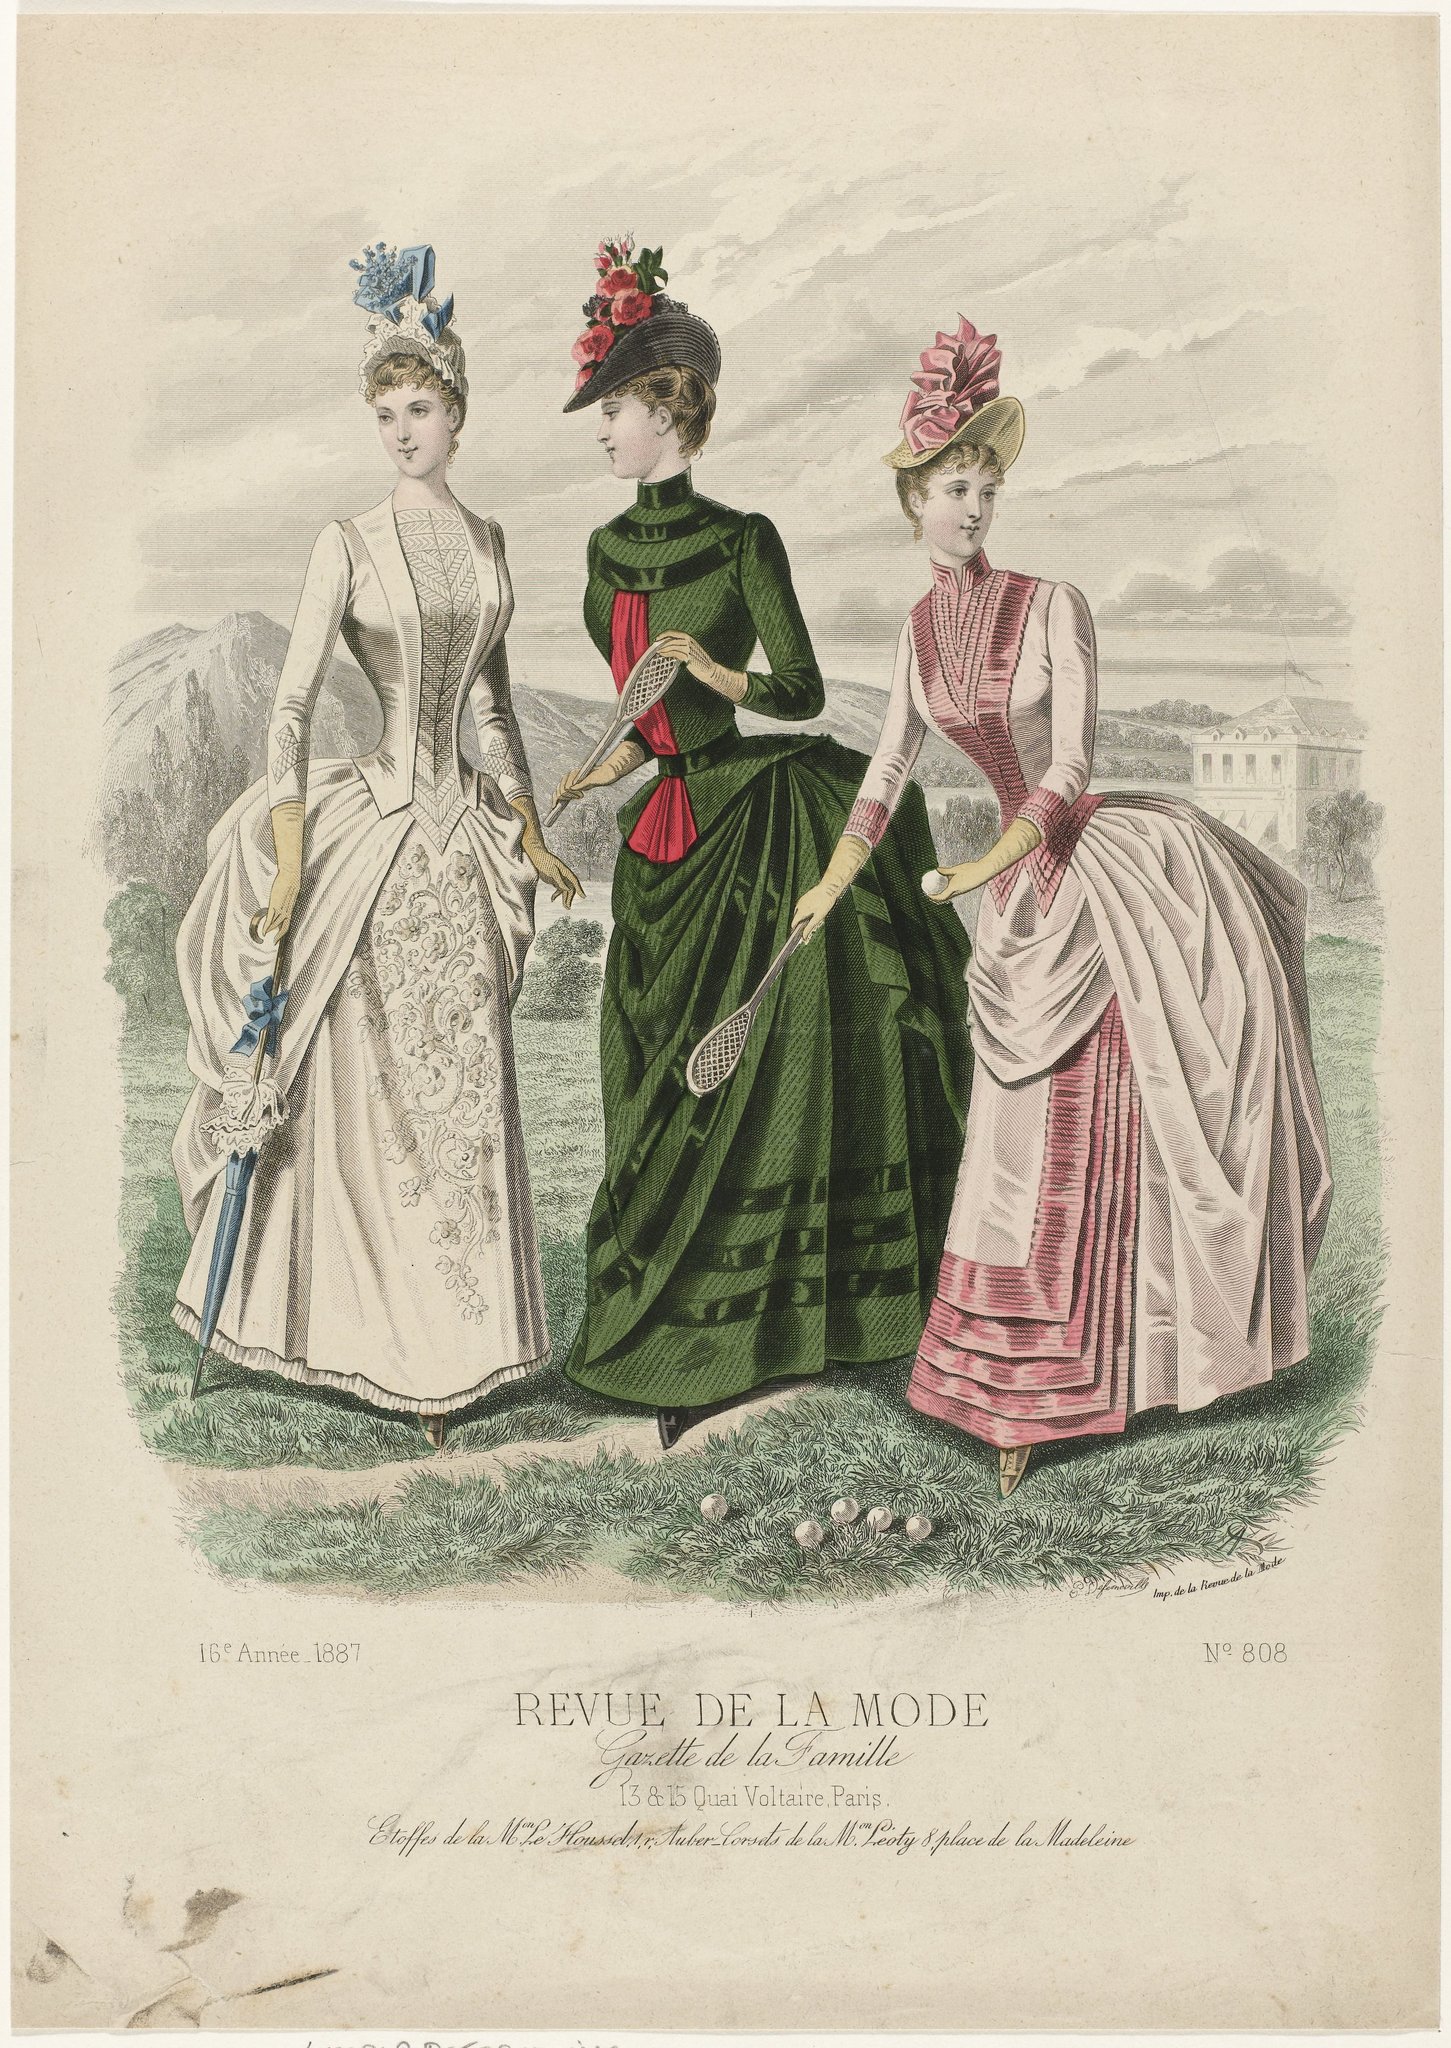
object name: fashion print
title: Revue de la Mode, Gazette de la Famille, dimanche 26 juin 1887, 16e Année, No. 808: Etoffes de la M.on Le Houssel (...)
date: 1887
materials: paper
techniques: engraving, hand coloring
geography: paris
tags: head-gear (capote) (+ women's clothes), walking-stick, staff, cane (+ women's clothes), embroidery (ornamentation) (+ women's clothes), border, ribbon, braid (+ women's clothes), tennis, lawn-tennis (+ equipment, outfit (sports, games, etc.)), flowers: forget-me-not, head-gear (straw hat) (+ women's clothes), fashion plates, skirt (+ women's clothes), dress, gown (+ women's clothes), flowers: rose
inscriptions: address: ‘13 & 15, Quai Voltaire, Paris’, title: ‘REVUE DE LA MODE / Gazette de la Famille’, caption: ‘Etoffes de la M.on Le Houssel 1 r. Auber. _ Corsets de la M.on Léoty, 8, place de la Madeleine.’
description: Drie vrouwen op een grasveld, twee hebben een tennisracket in de hand. Links: japon van witte wol, witte zijde, soutaché van witte wol en galon van witte zijde. Rok met tablier geborduurd met witte soutache. Capote van kant versierd met vergeet-mij-nietjes (myosotis) en 'coques' van lichtblauw lint. Midden: japoon van donkergroene wol, donkergroen fluweel en 'rode surah'. Rok van groene wol versierd met drie rijen van donkergroene fluwelen linten. Strohoed versierd met rode rozen en groen fluweel lint. Rechts: japon van lichtroze doek en roze faille. Hoed van lichtgeel stro en roze zijde, versierd met een gestrikt lint van roze faille (Model van Gellèe). Onder de voorstelling een regel reclametekst voor verschillende producten. Prent uit het modetijdschrift Revue de la Mode (1872-1913). Uitgebreide beschrijving van de kleding op pagina 204 en 205 "PLANCHE COLORIÉE".